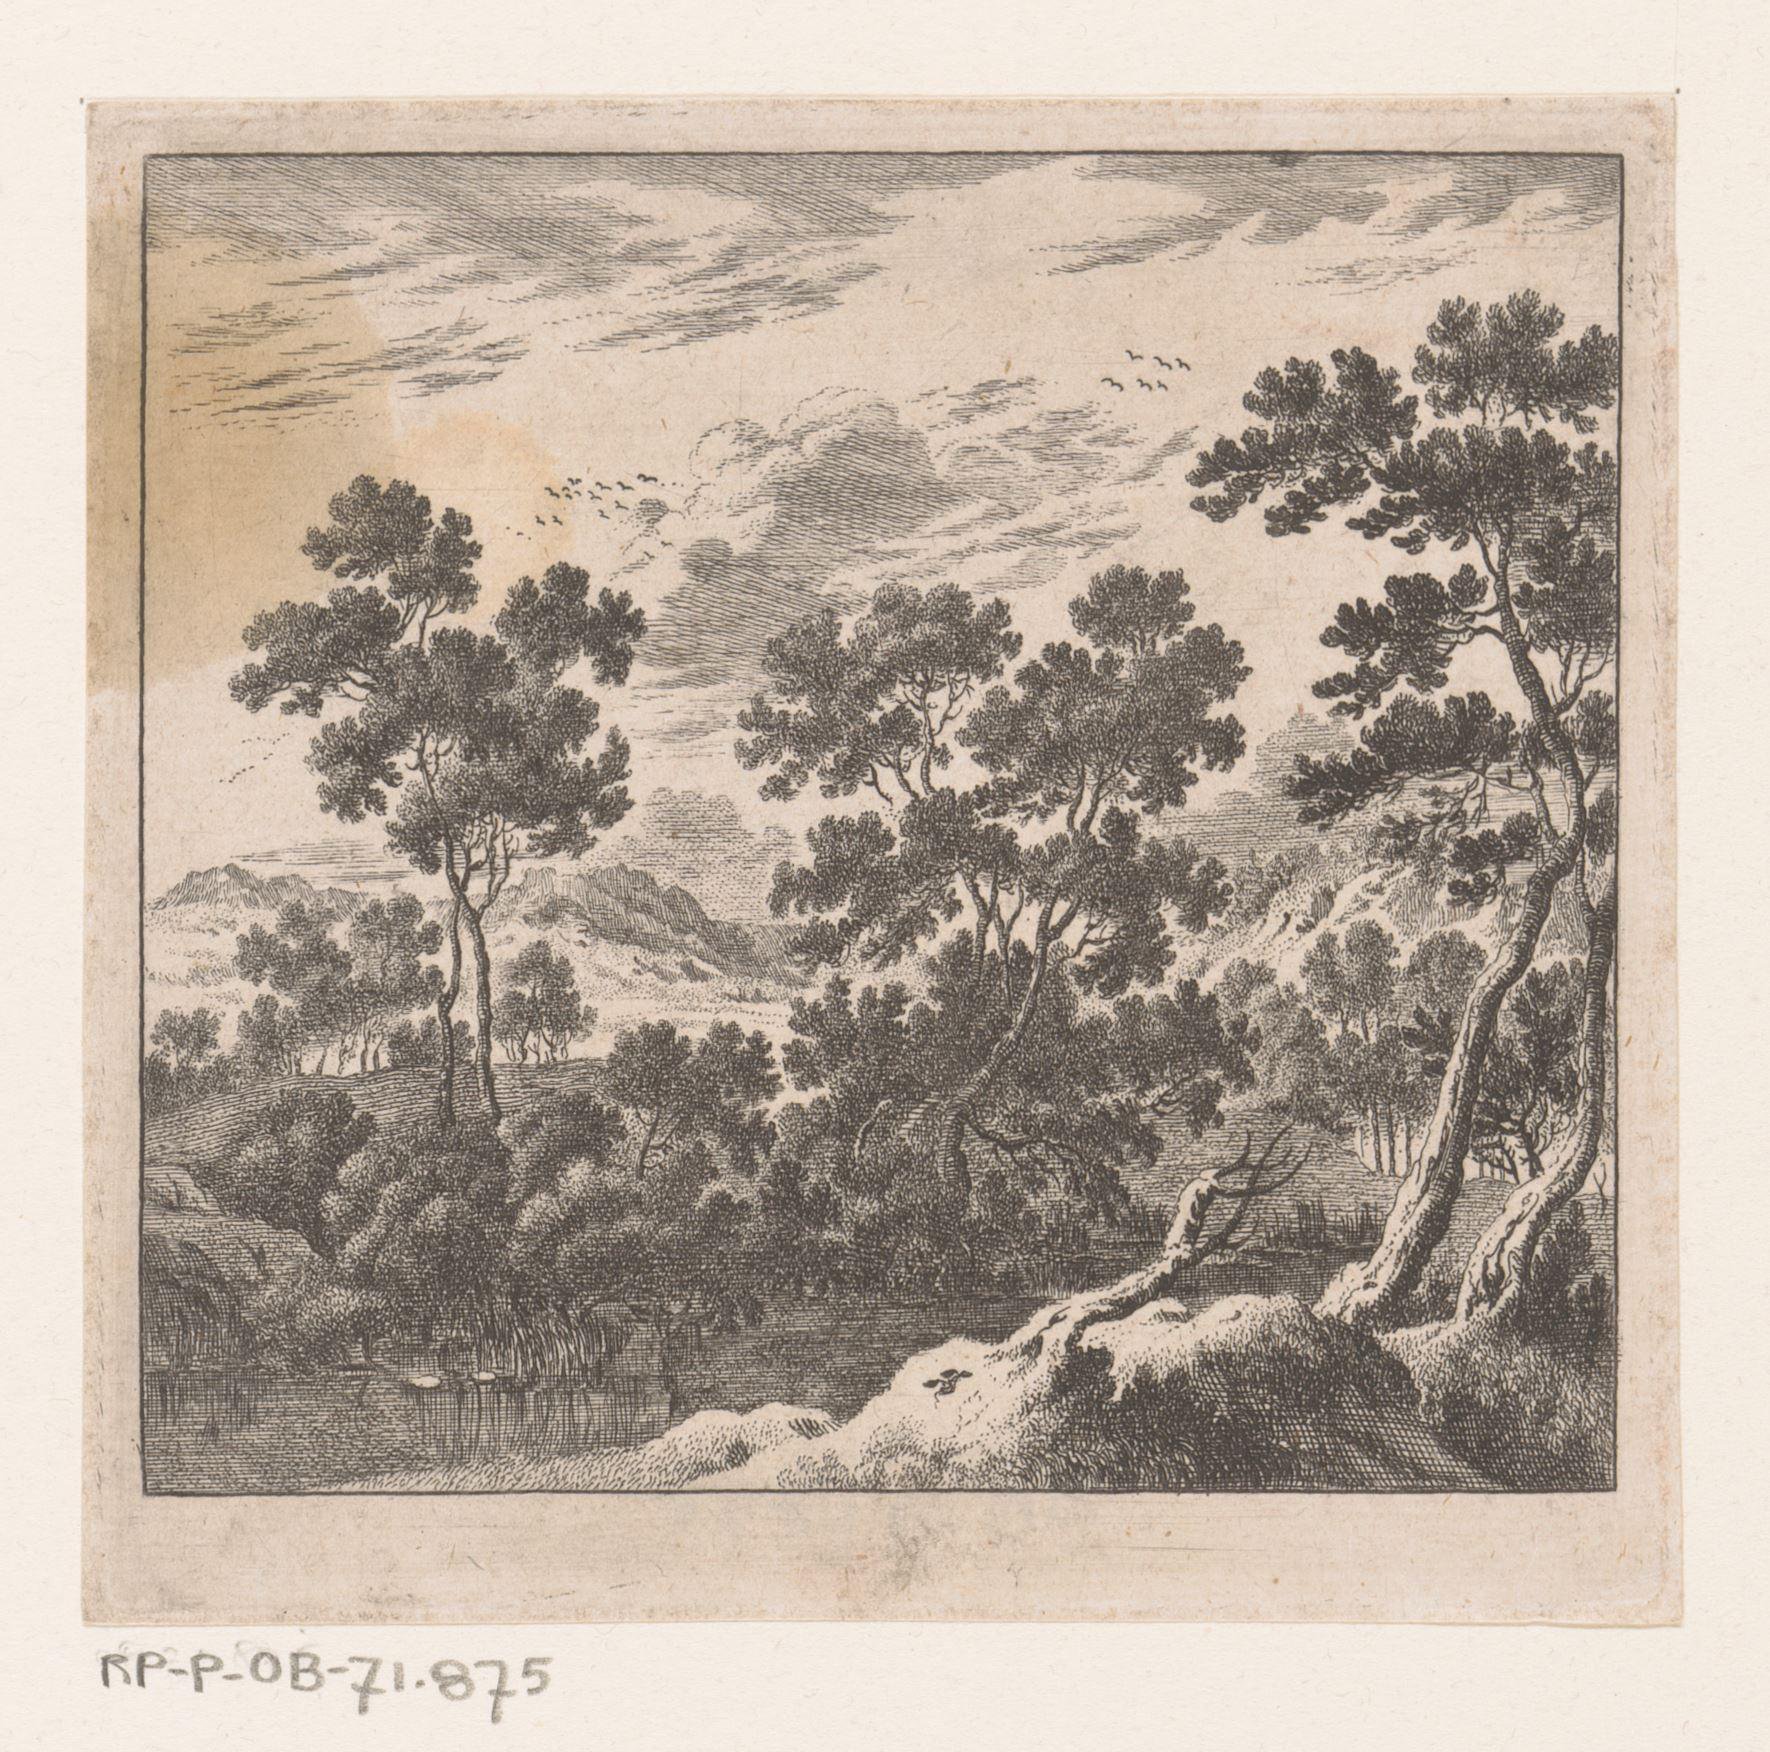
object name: print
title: Landschap met bomen en rivier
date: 1613-1695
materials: paper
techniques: etching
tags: landscapes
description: Prenten met het signatuur 'Perelle' kunnen zowel door vader Gabriel als door zonen Nicolas en Adam gemaakt zijn.